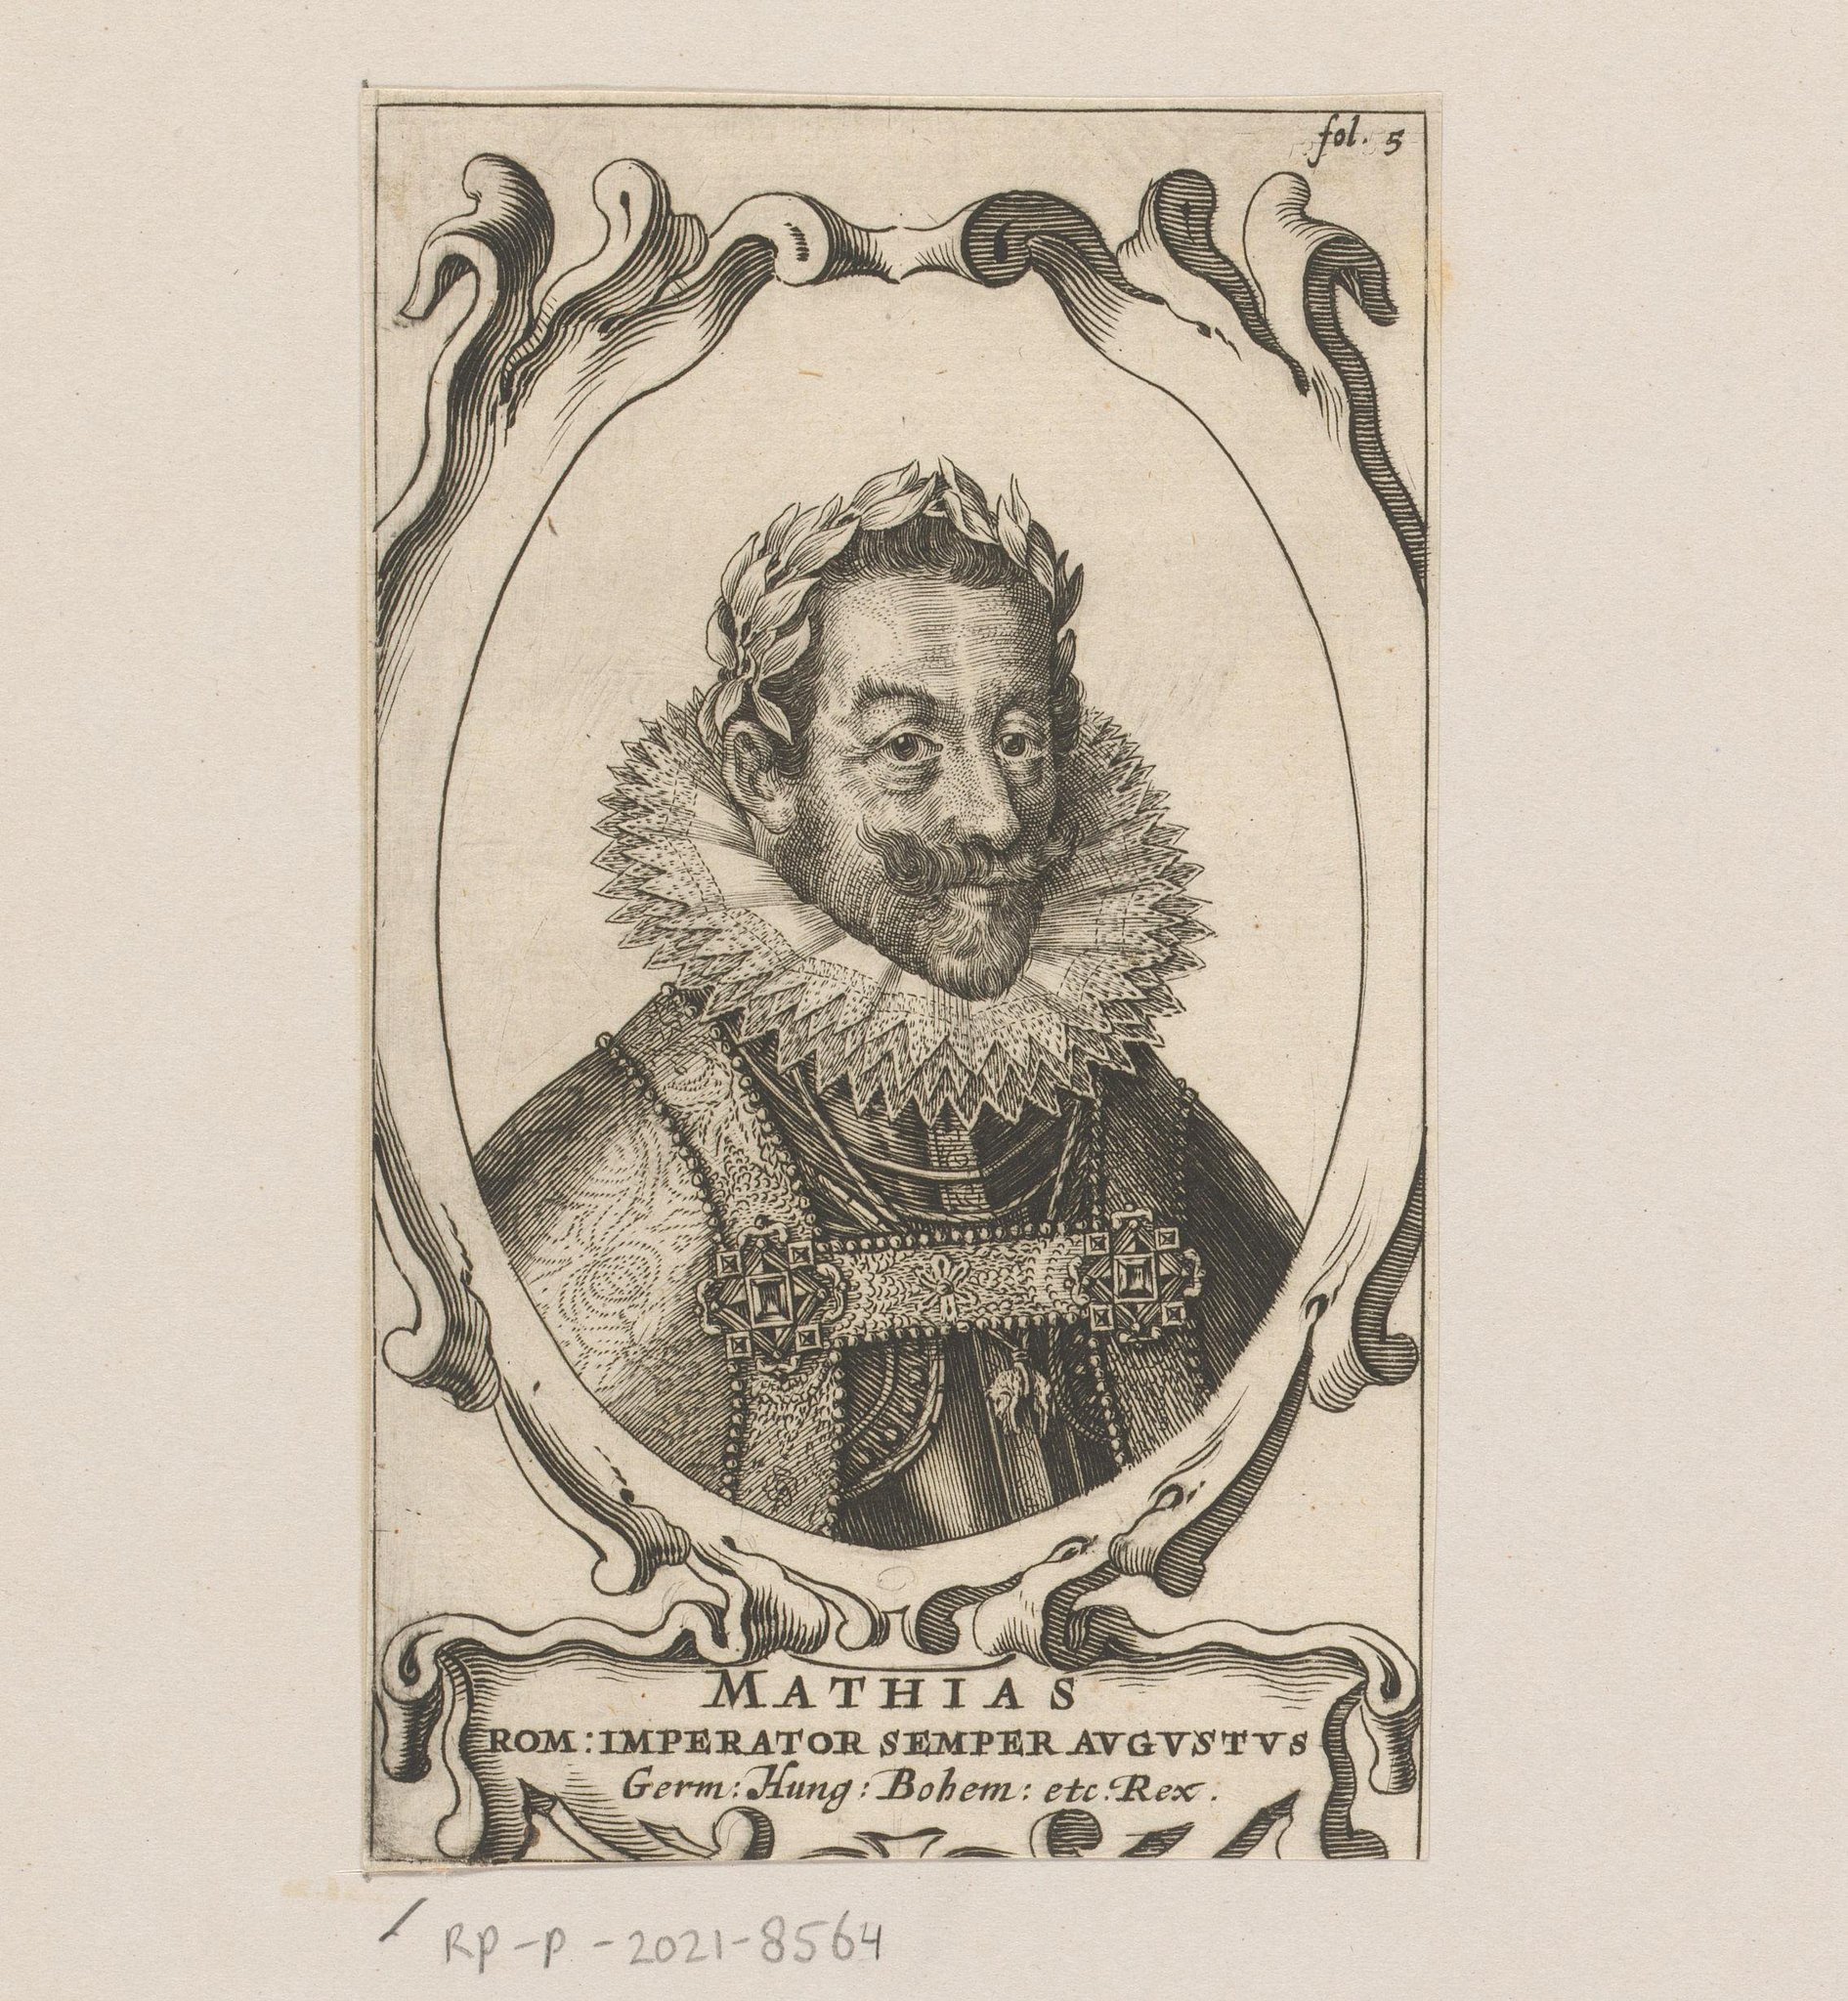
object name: print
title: Portret van keizer Matthias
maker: Anonymous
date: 1656-1666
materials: paper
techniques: engraving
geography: northern netherlands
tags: vienna, matthias van oostenrijk (rooms-duits keizer), rocaille ornament, historical persons, emperor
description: Prent waarschijnlijk uit: Brachelius, Johannes Adolphus. Historia nostri temporis, dat is geschiedenis onses tijts (…). Rotterdam: Andries van Hoogenhuysen, 1656. Prent ook gebruikt in de 1659- en 1666-editie.